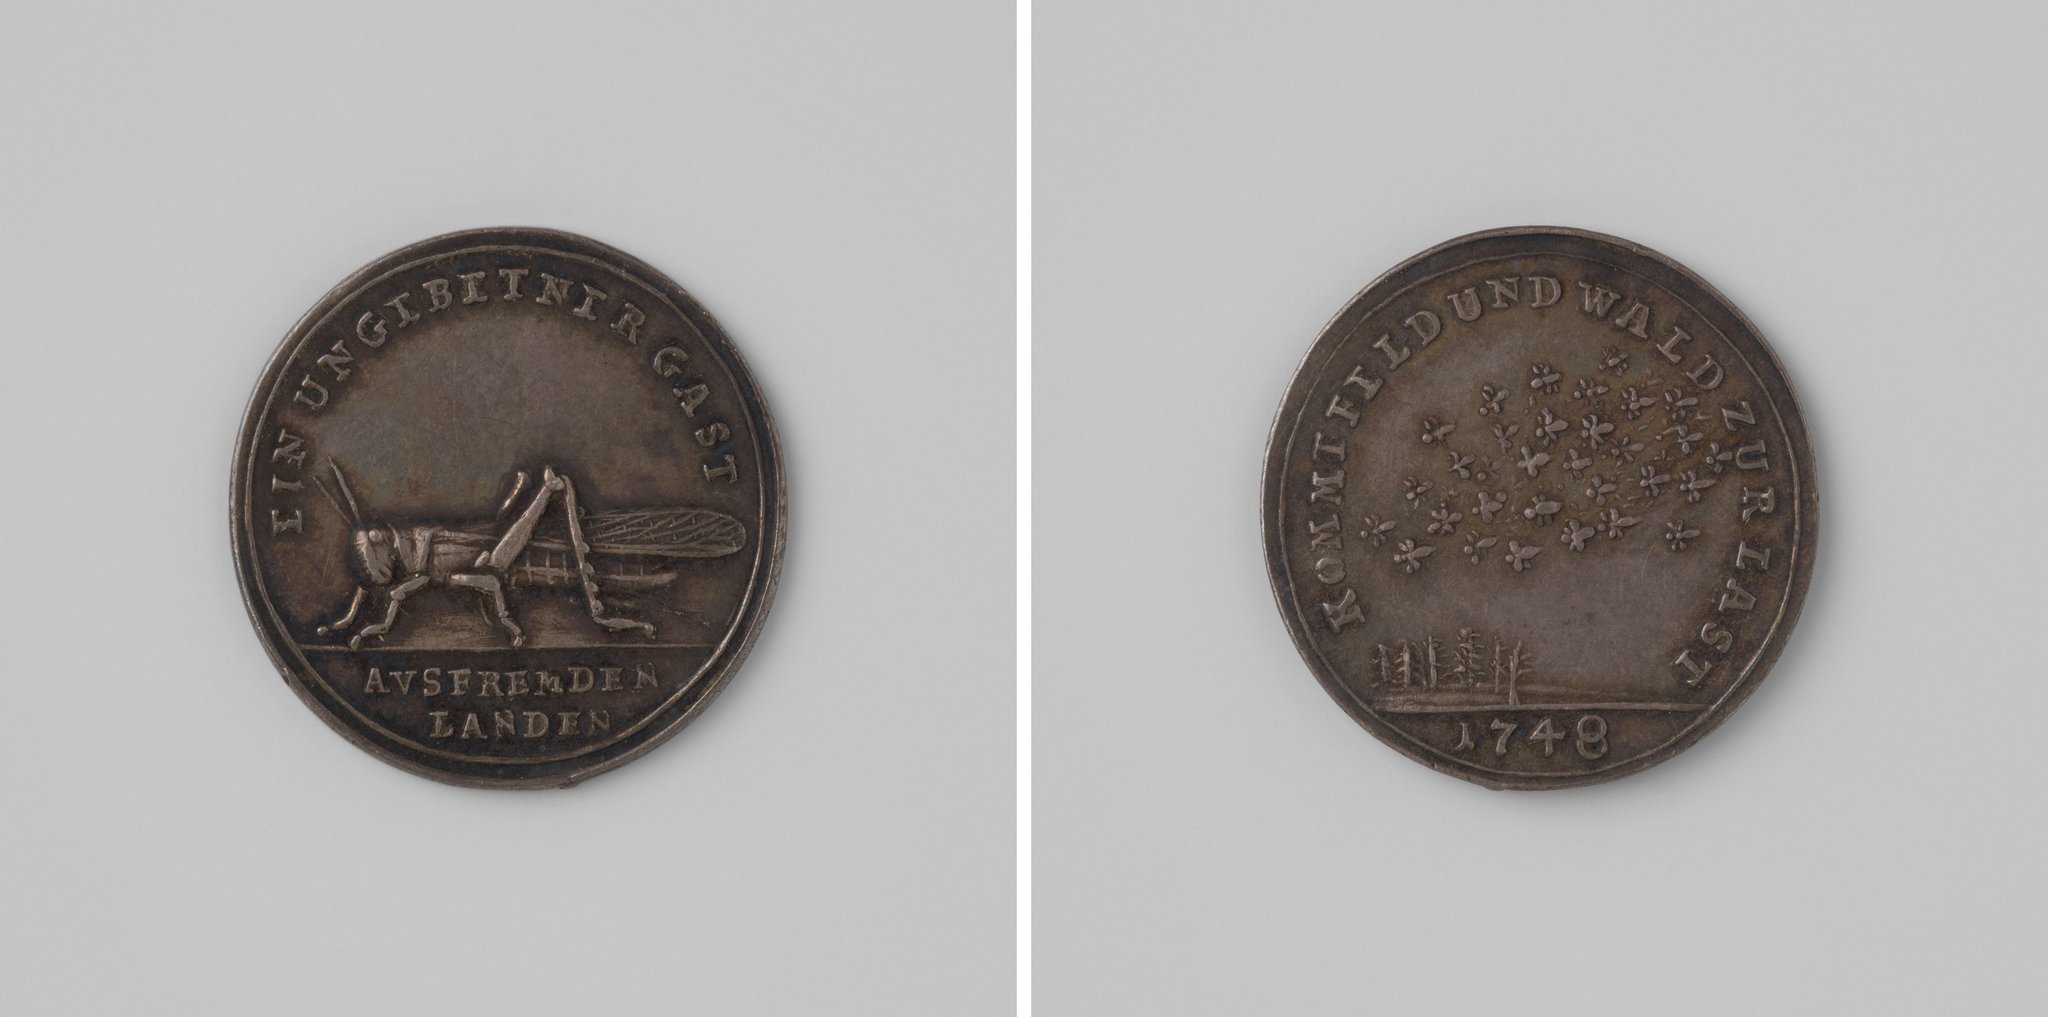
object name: history medal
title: Sprinkhanenregen in Duitsland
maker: Anonymous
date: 1748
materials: silver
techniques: striking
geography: germany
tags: germany